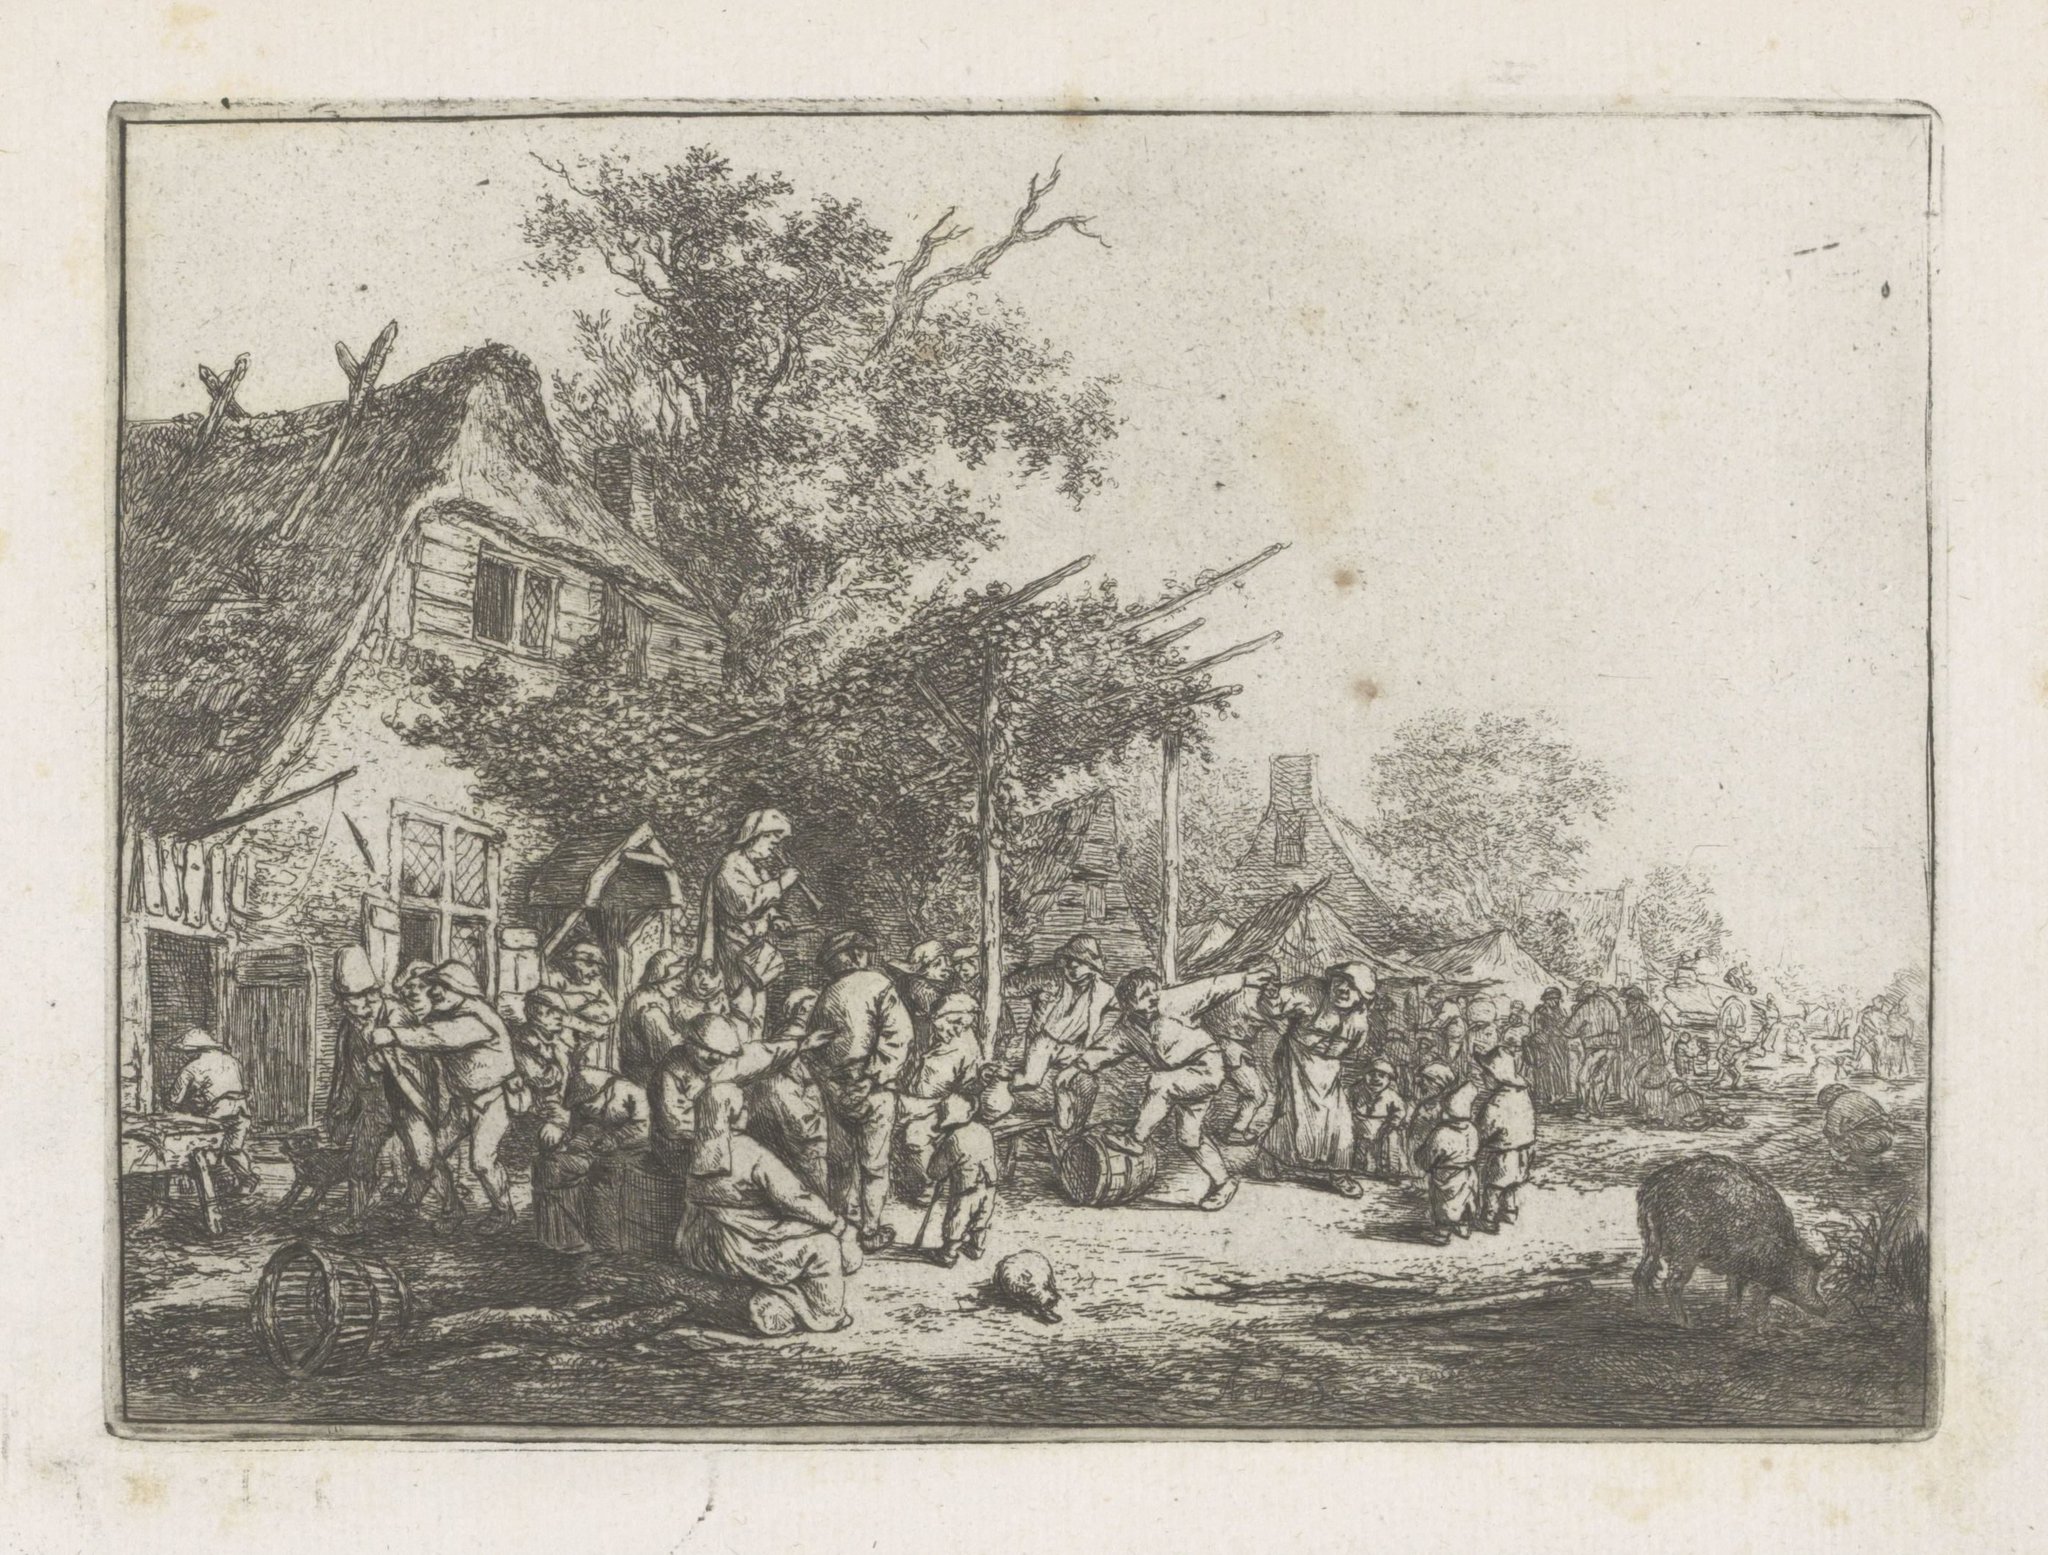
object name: print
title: Dansende boeren voor een herberg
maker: adriaen van ostade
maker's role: draughtsman, painter, print maker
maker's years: 1610-1685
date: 1651-1655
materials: paper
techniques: etching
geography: haarlem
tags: flute, aulos, tibia - cc - out of doors (+ artist at work), inn, coffee-house, public house, etc., one pair dancing; man and woman dancing as a couple, public festivities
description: Links een fluitspeler op een verhoging naast een pergola. Deze prent maakt deel uit van een album.